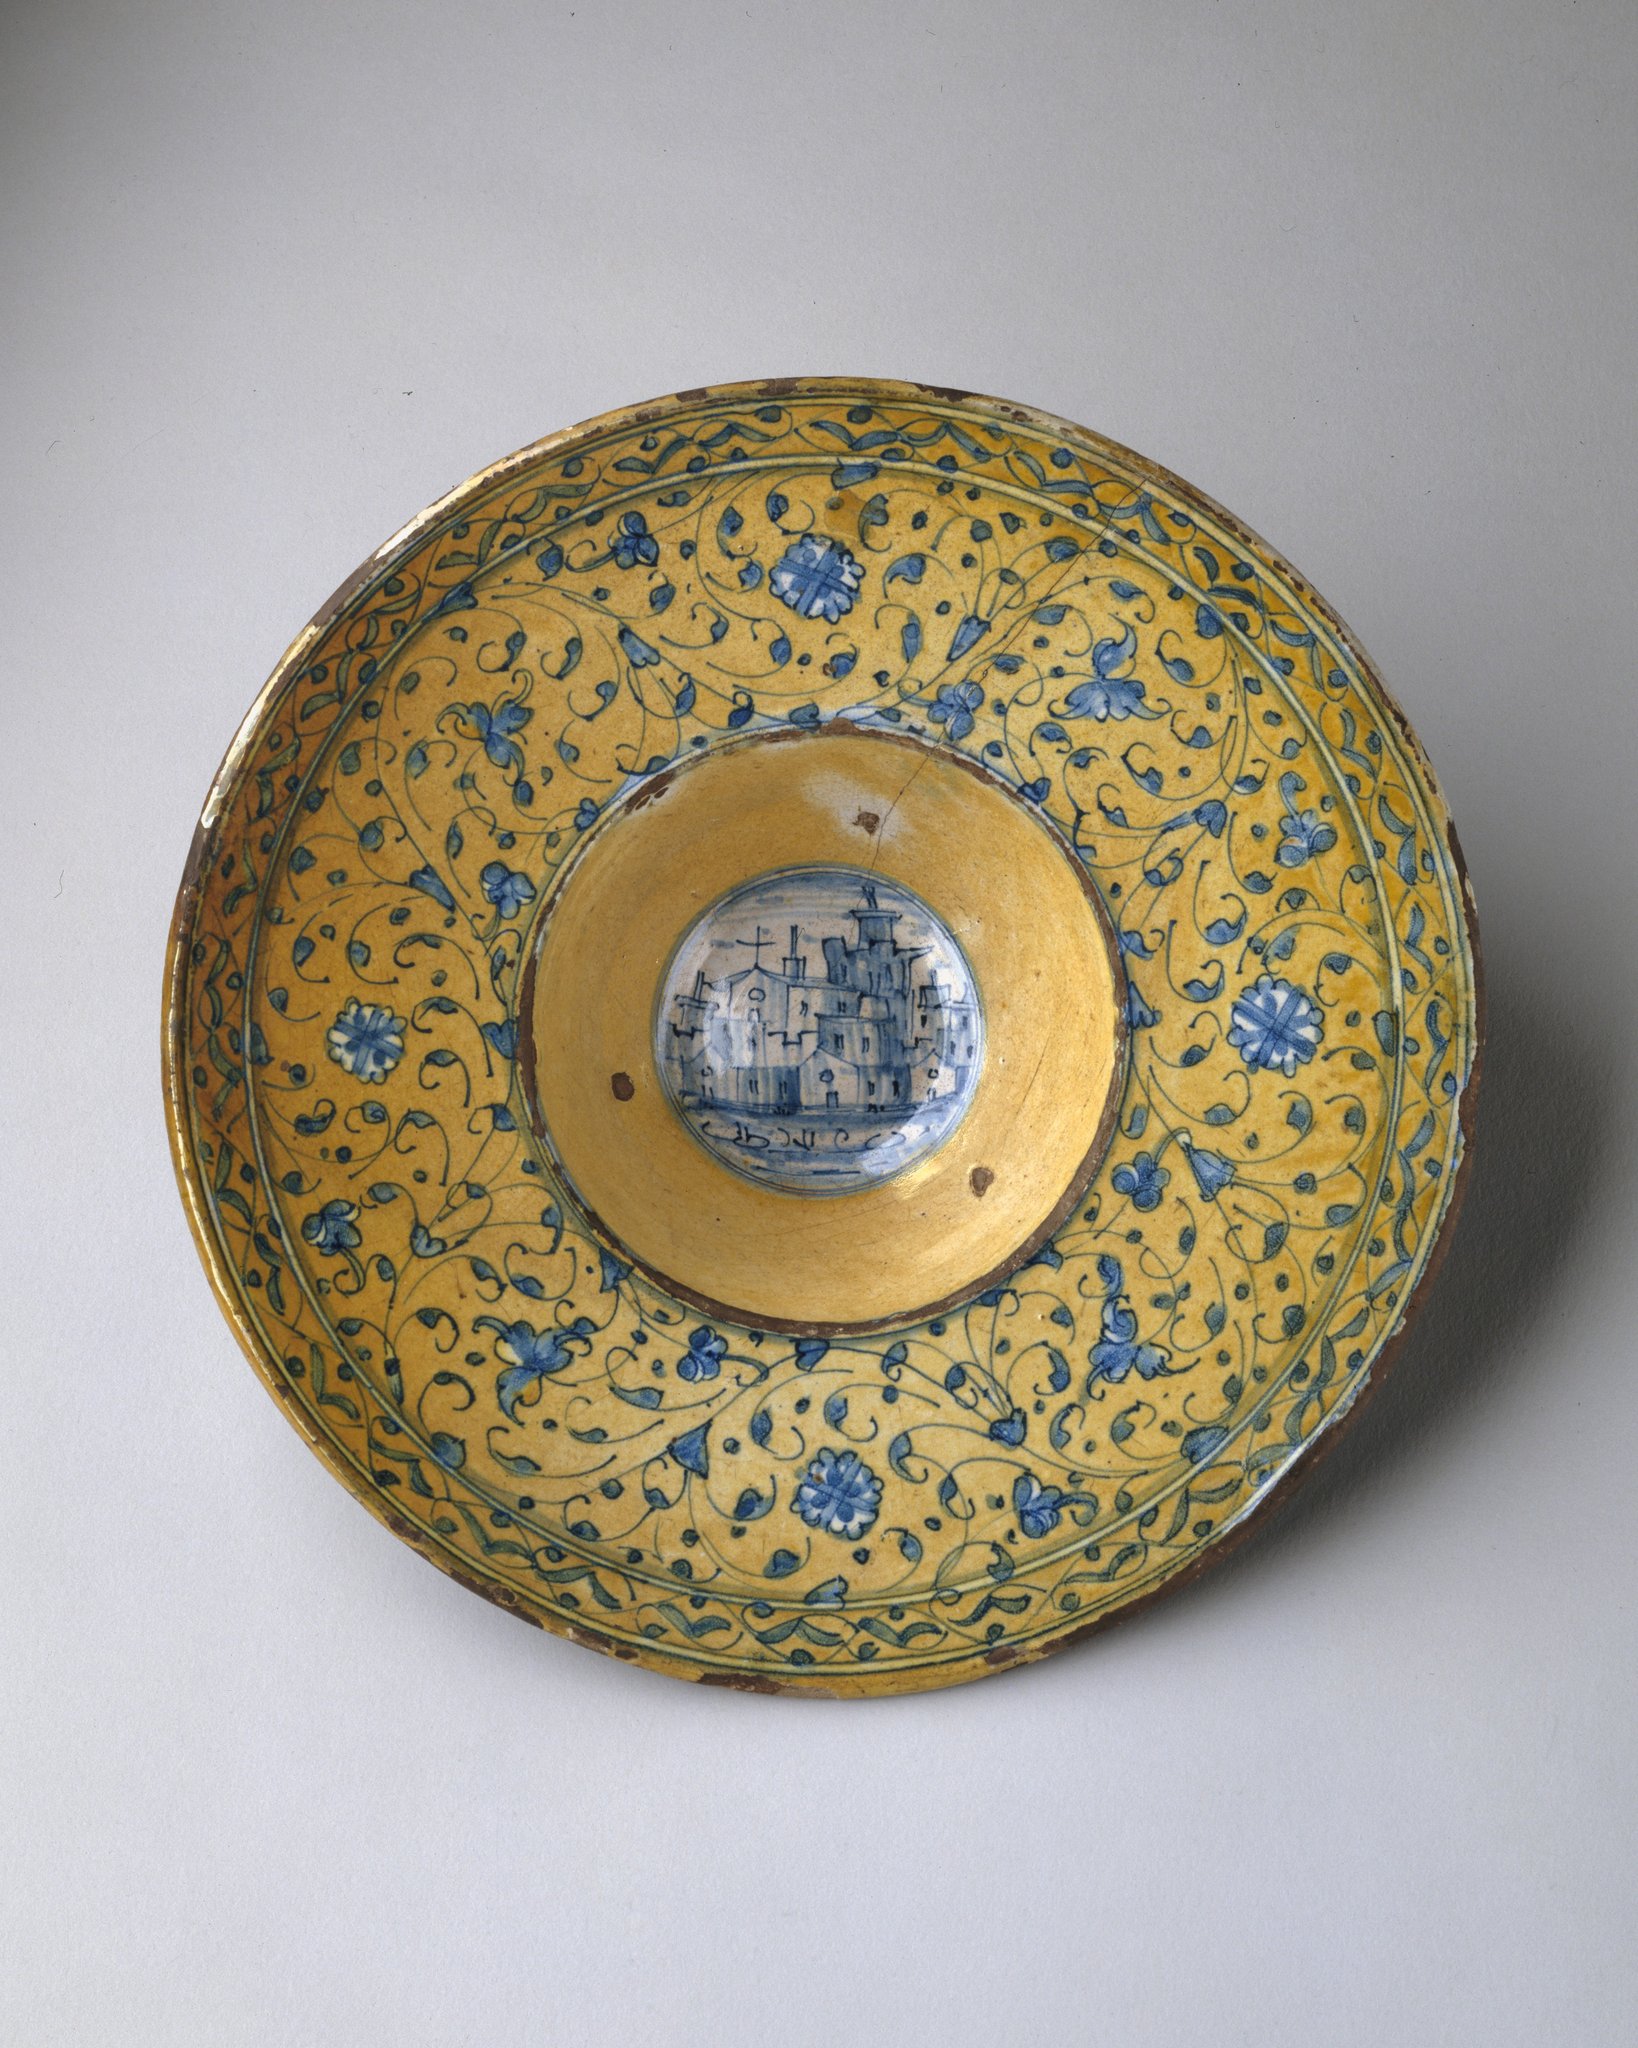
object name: dish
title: Dish (tondino)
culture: italian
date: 1570-1580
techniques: maiolica, glazing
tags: buildings